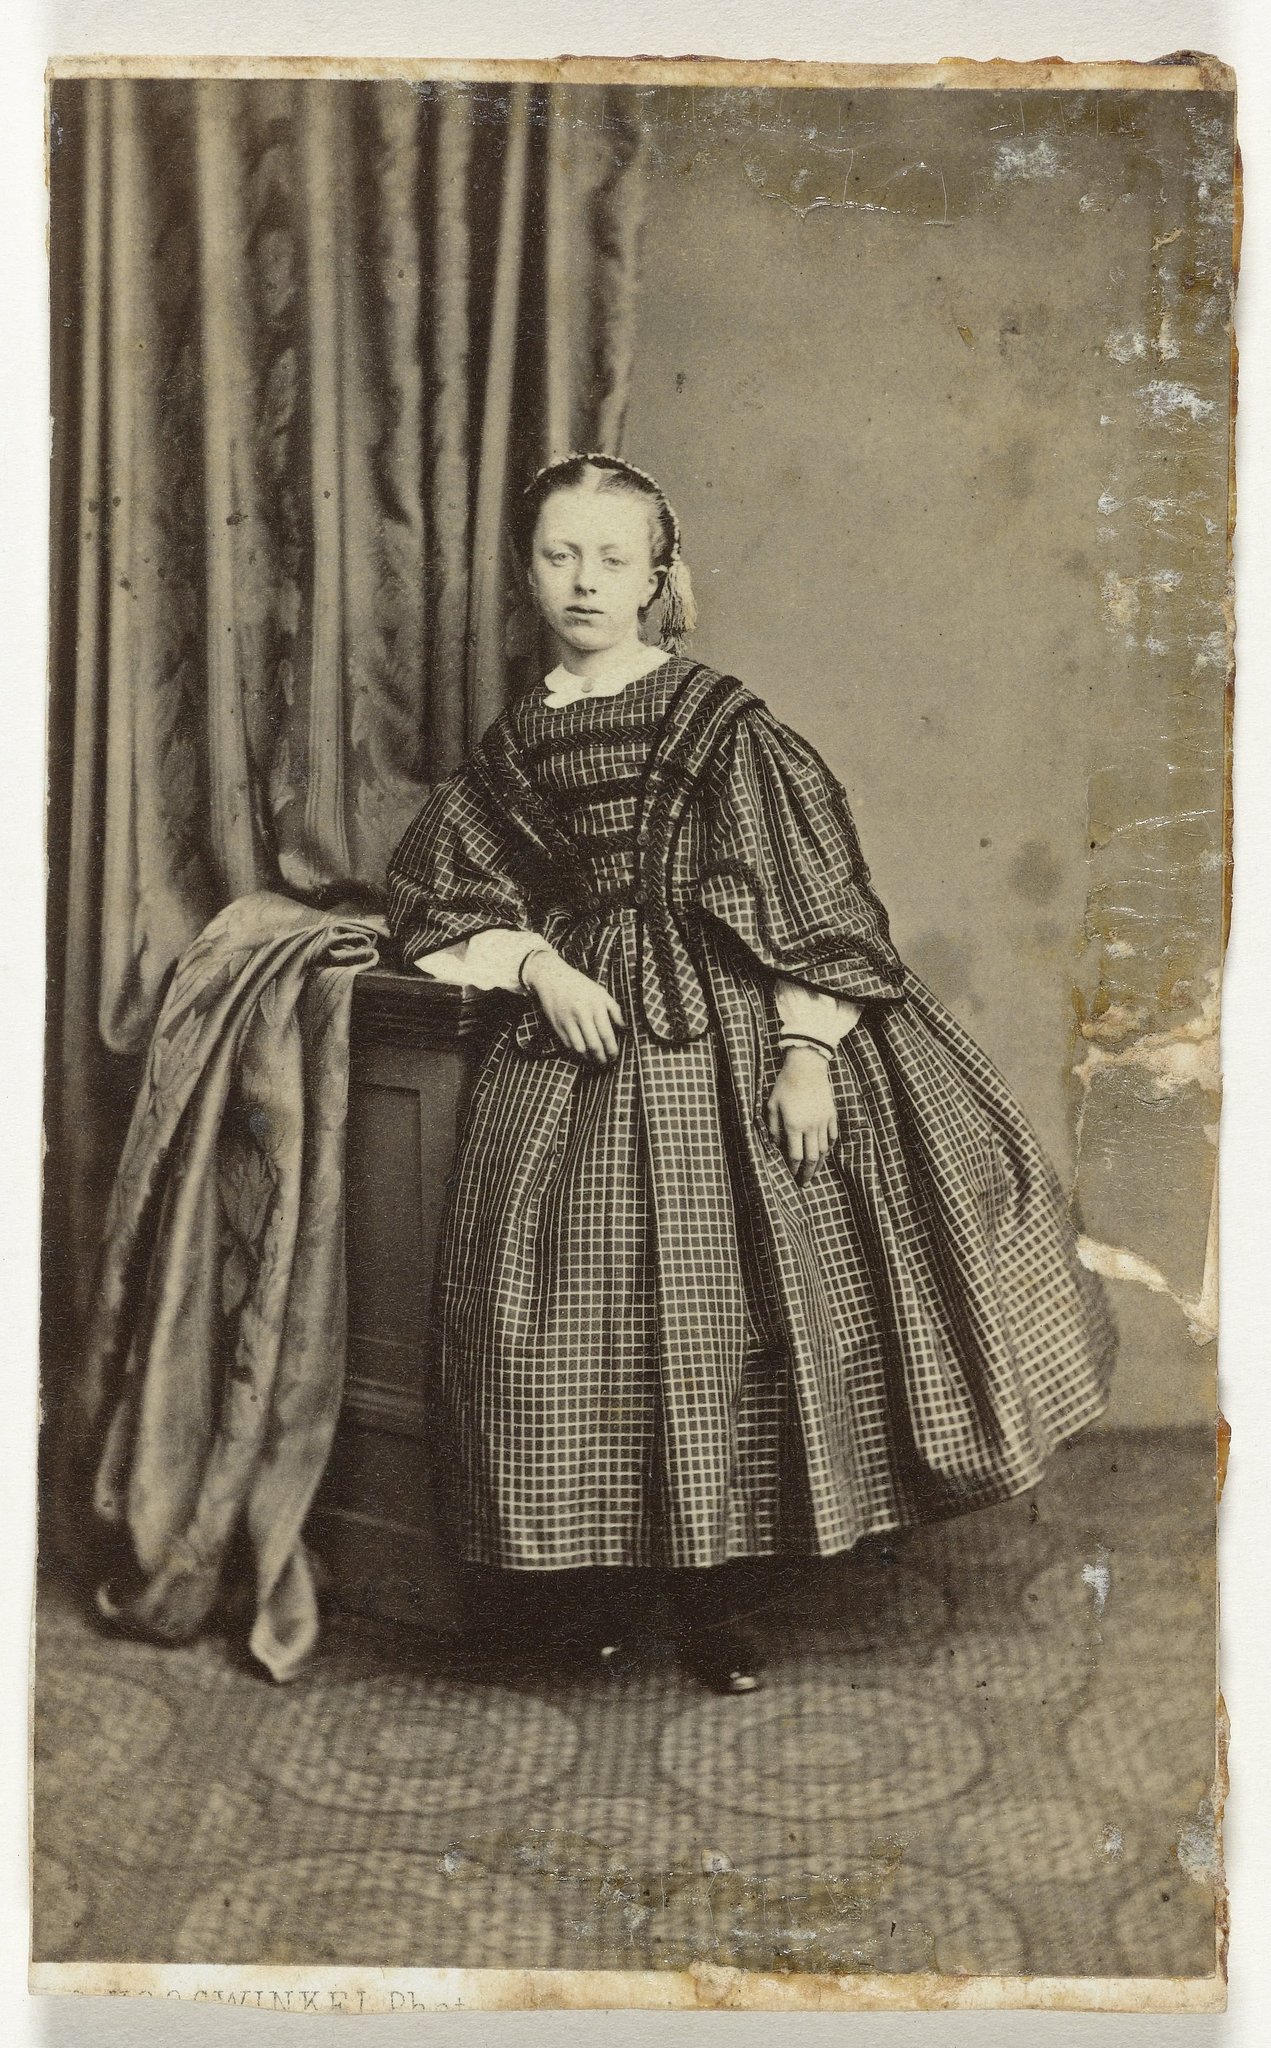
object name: carte de visite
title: Portret van een meisje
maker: gerrit hoogwinkel jr.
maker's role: fotograaf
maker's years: 1837-1890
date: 1860-1865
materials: cardboard, paper, photographic support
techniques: albumen print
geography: rotterdam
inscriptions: coat of arms: ‘Je maintiendrai’, address: ‘G. Hoogwinkel/Photographe/Rotterdam’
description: Staand meisje in een geruite japon, leunend tegen sokkel waarover het achter haar hangende gordijn gedrapeerd is.